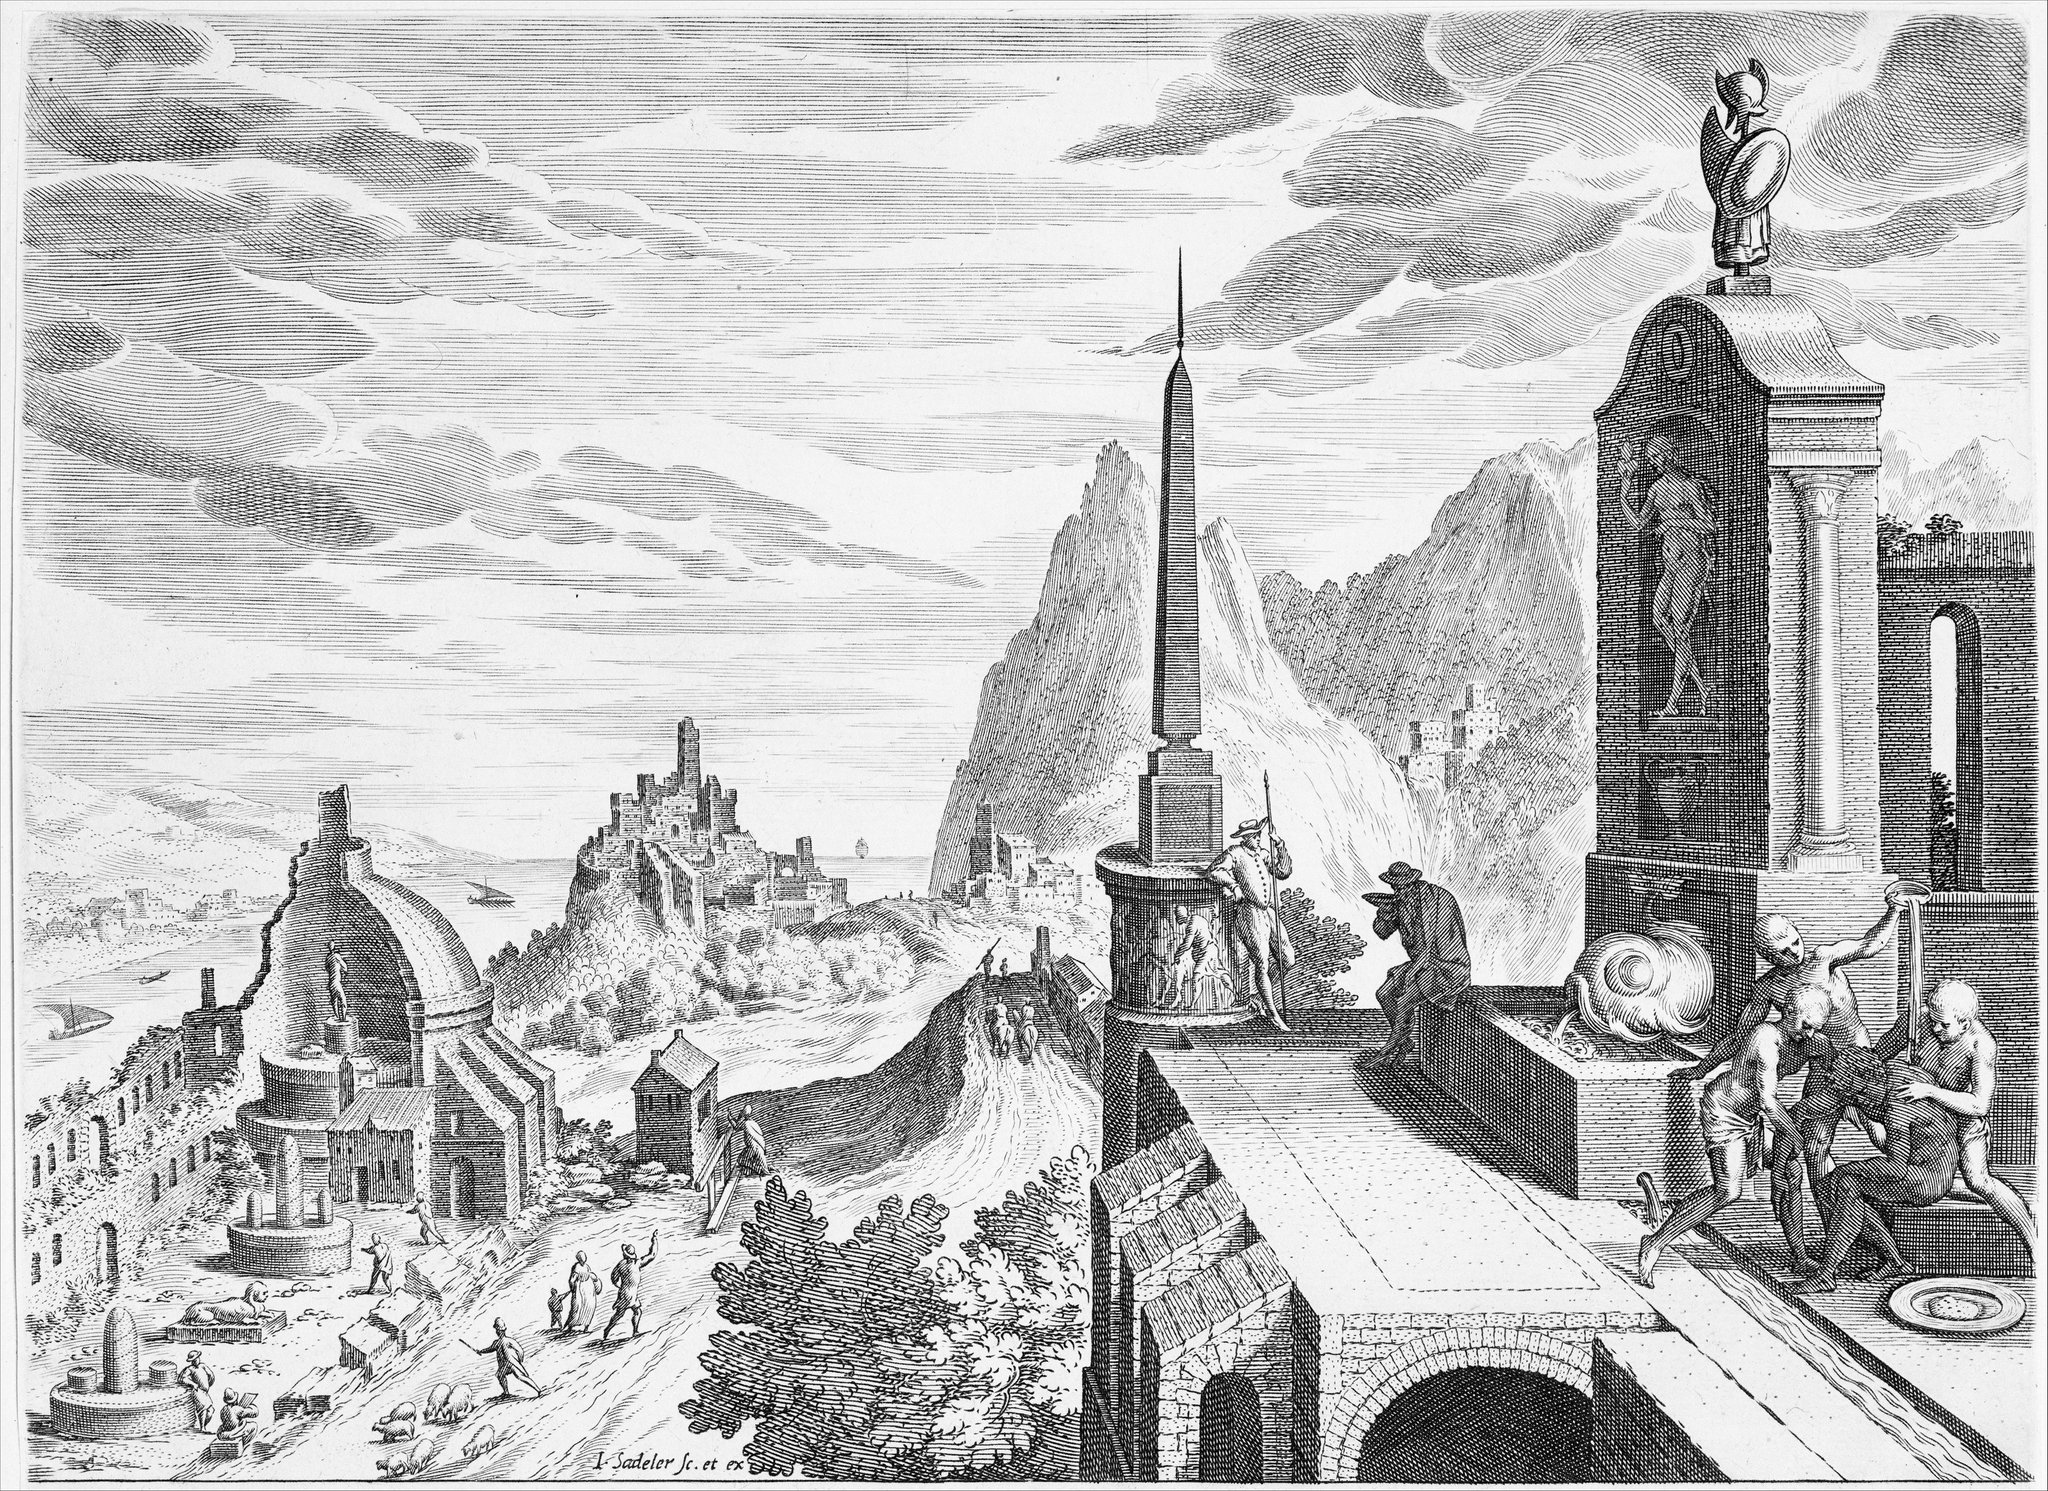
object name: print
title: Rocky Landscape with Antique Buildings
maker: johann sadeler (i)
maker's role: artist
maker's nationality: netherlandish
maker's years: 1550-1601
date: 1568-1600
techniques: engraving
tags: buildings,landscapes